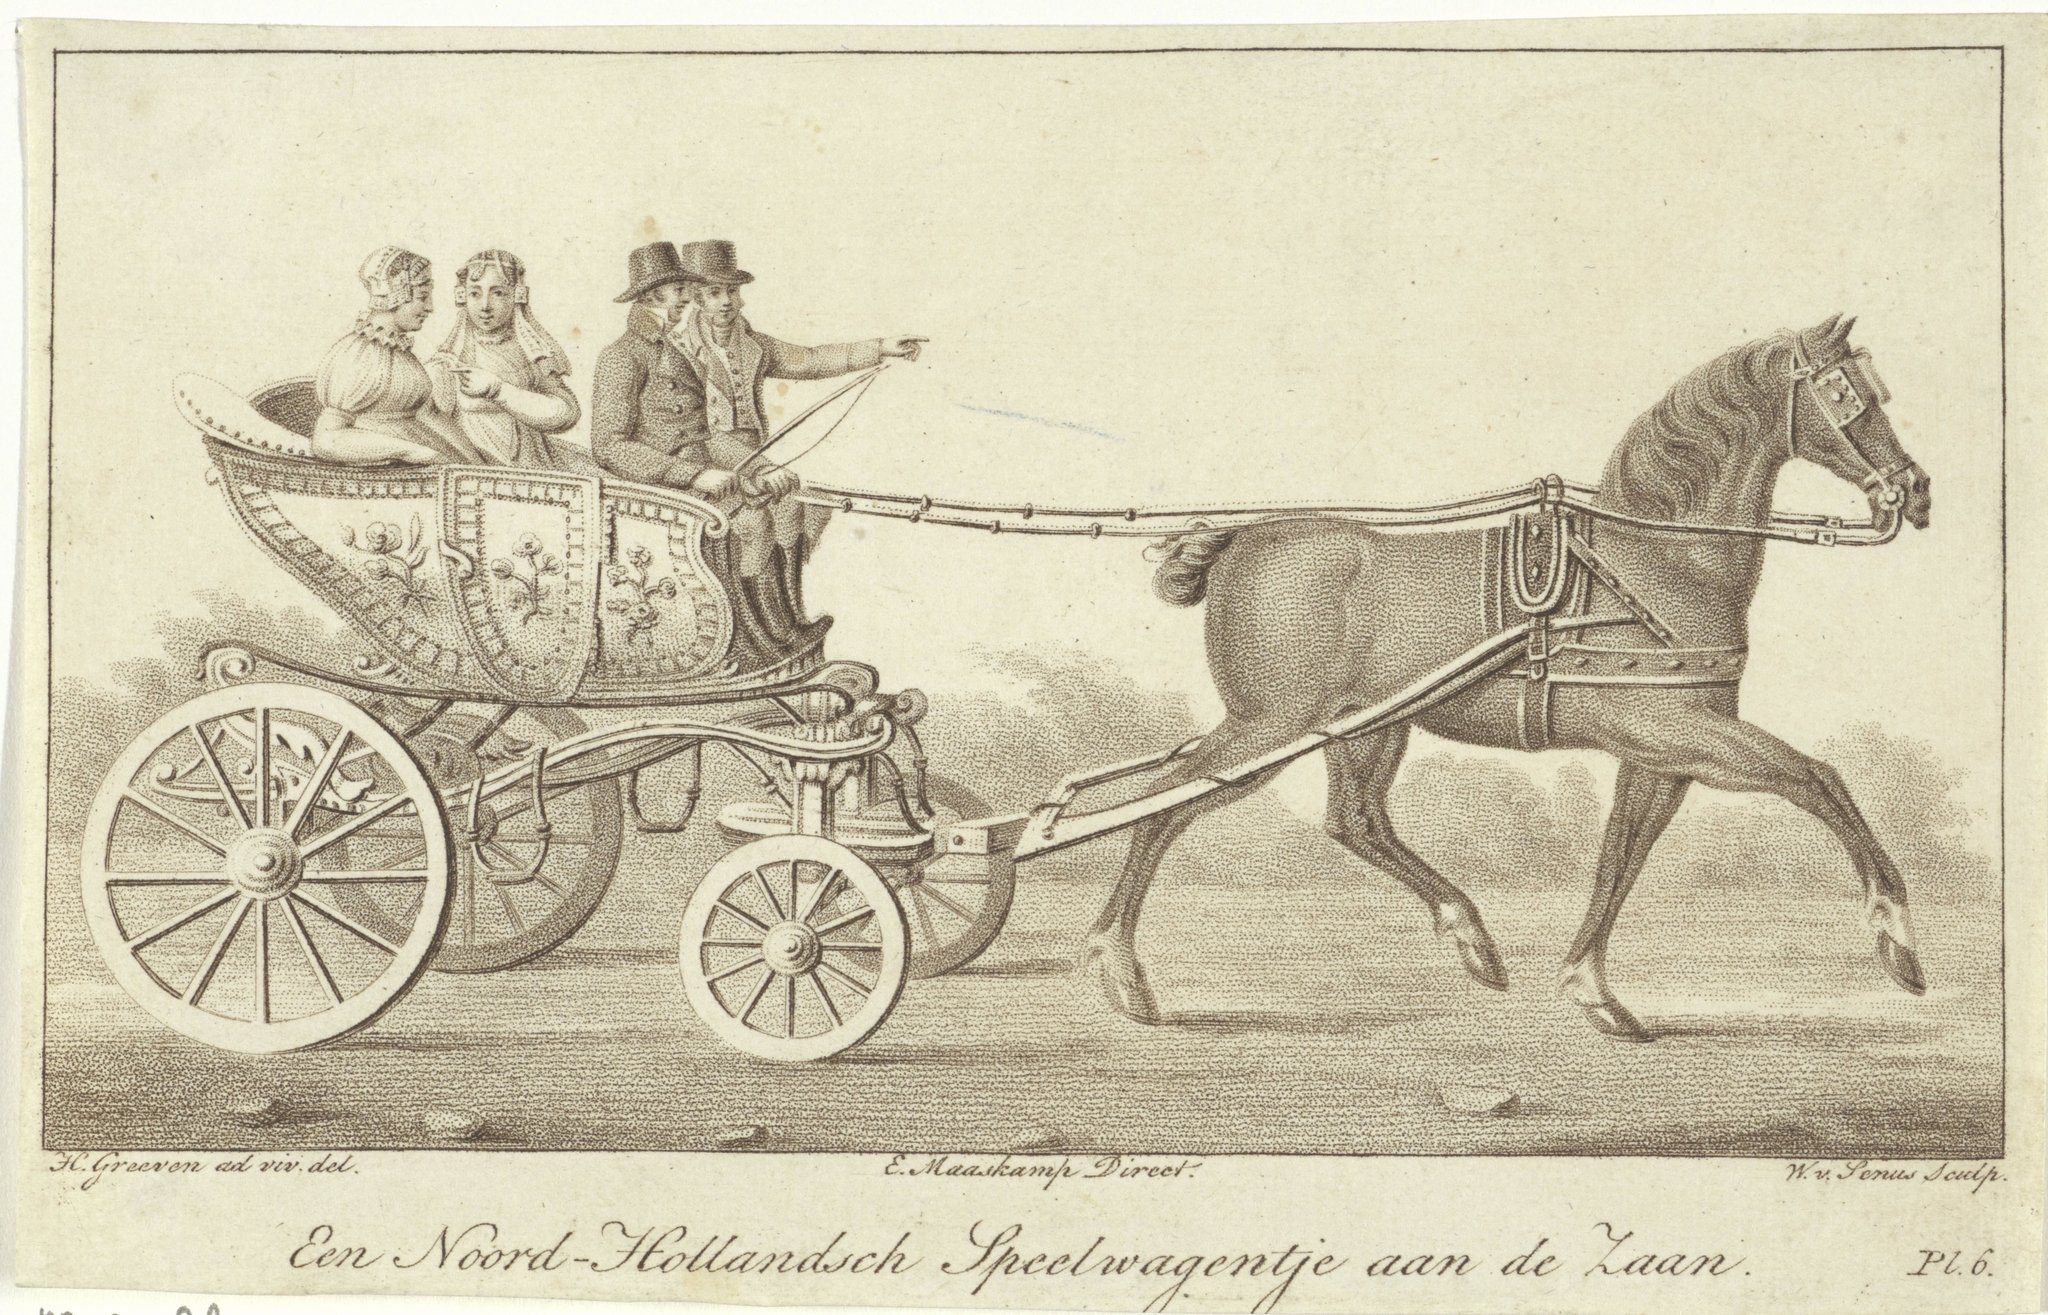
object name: print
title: Een Noord-Hollandsch Speelwagentje aan de Zaan/ Petite Caleche pour les parties de plaisir en Nordhollande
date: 1824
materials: paper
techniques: etching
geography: amsterdam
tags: four-wheeled vehicle drawn by one animal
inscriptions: collector's mark: Lugt 2228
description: Prent gebruikt in: Maaskamp, Evert. Tableau des principales vues des palais et édifices : représentations et des coutumes et usages, dans les provinces septentrionales du Royaume des Pays-Bas. Amsterdam, 1824.